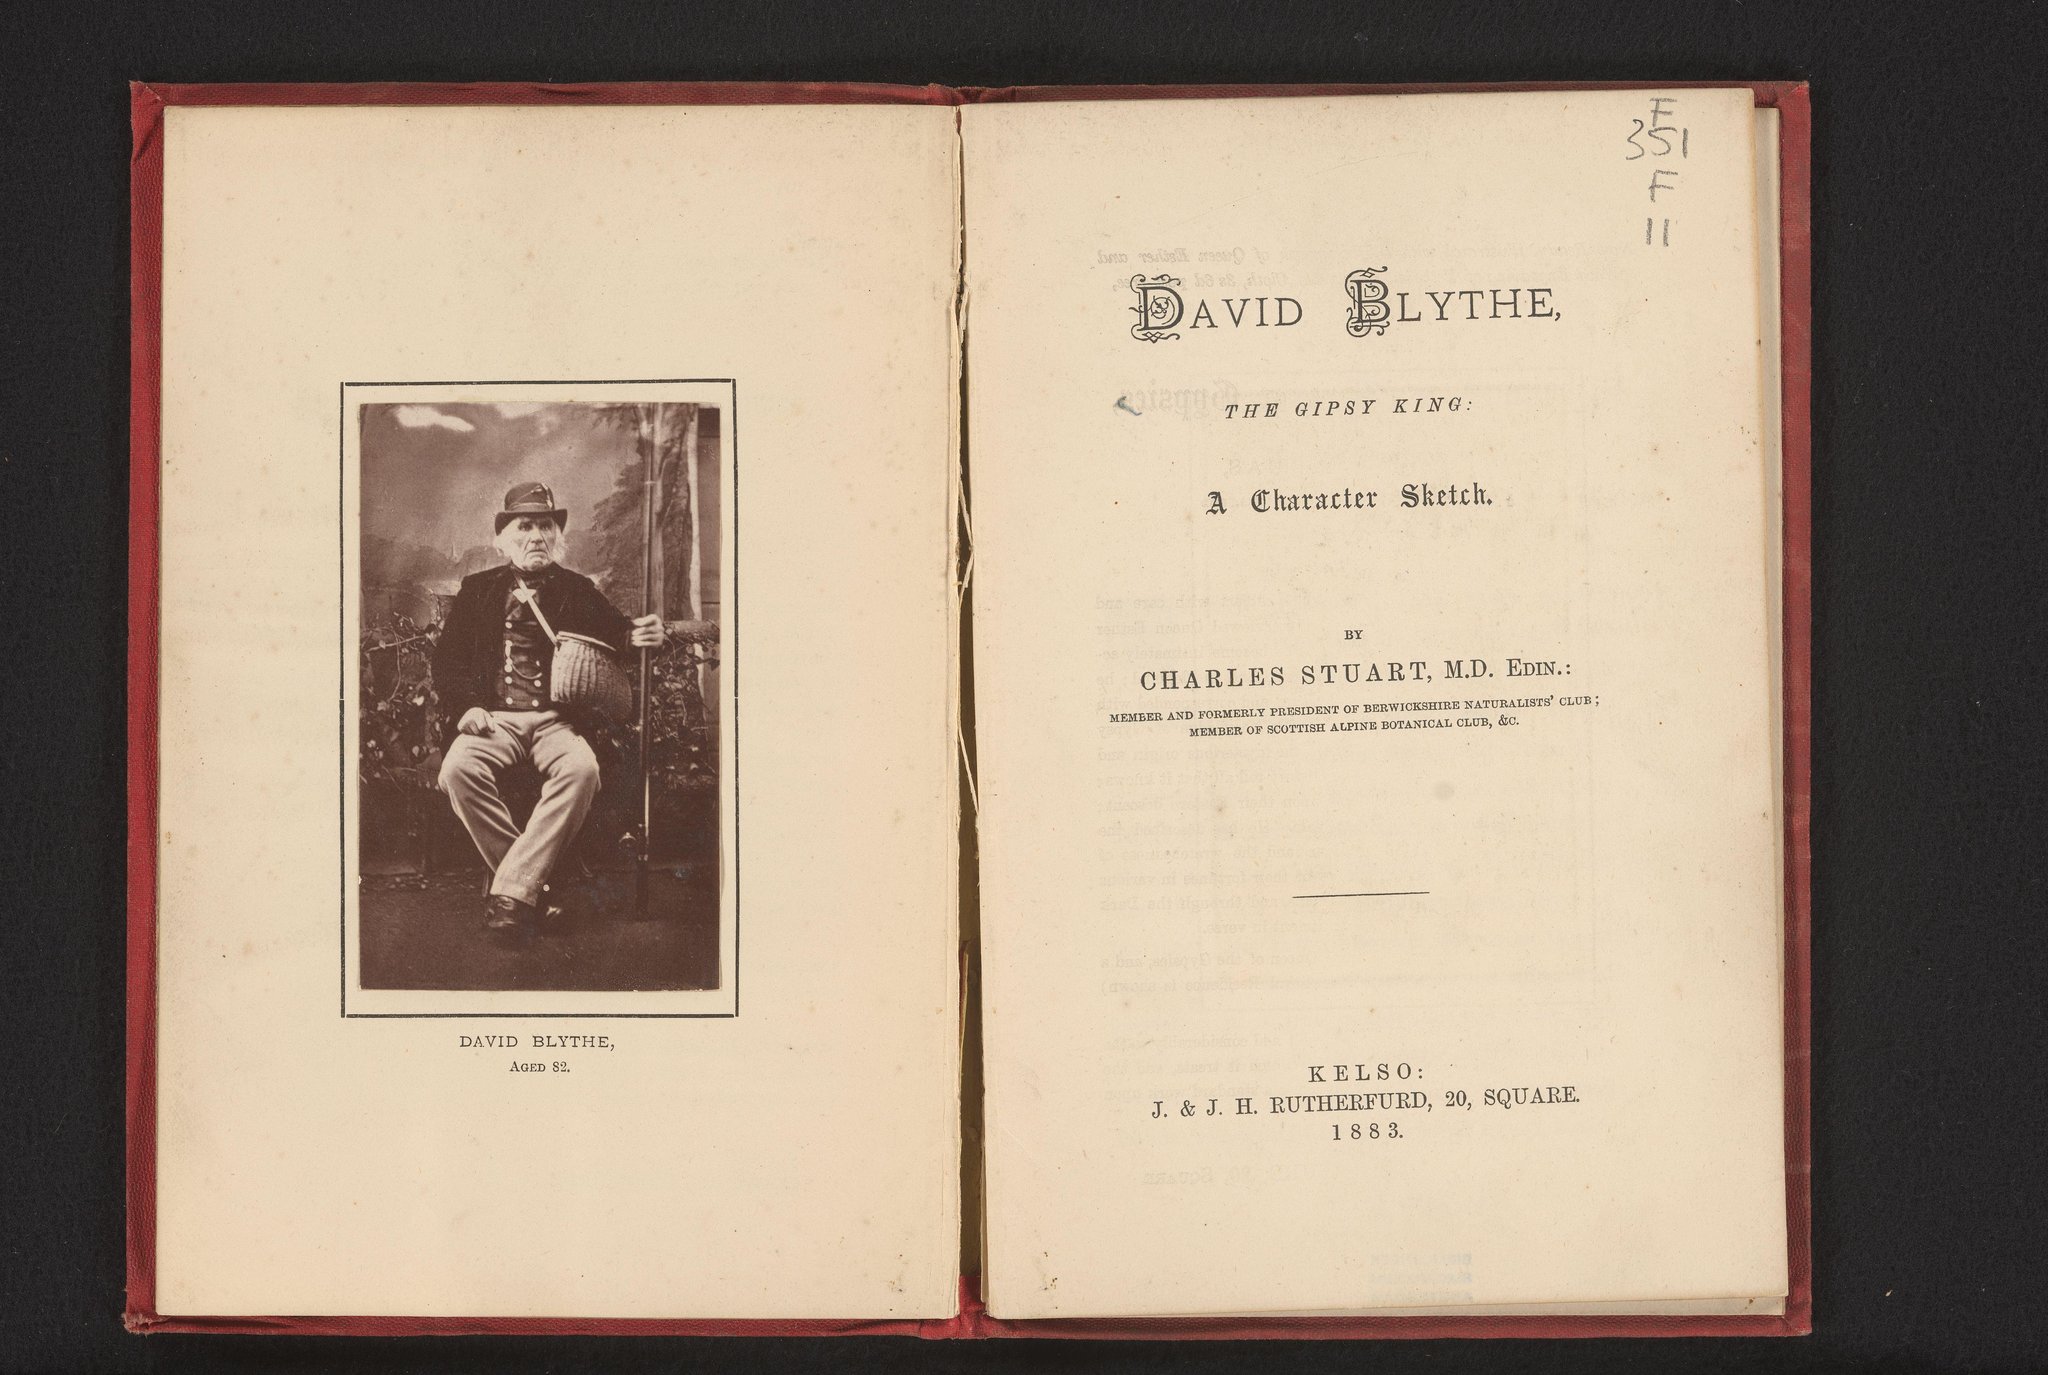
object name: photomechanical print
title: Portret van David Blythe op 82-jarige leeftijd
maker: Anonymous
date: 1877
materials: paper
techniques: woodburytype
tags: historical persons